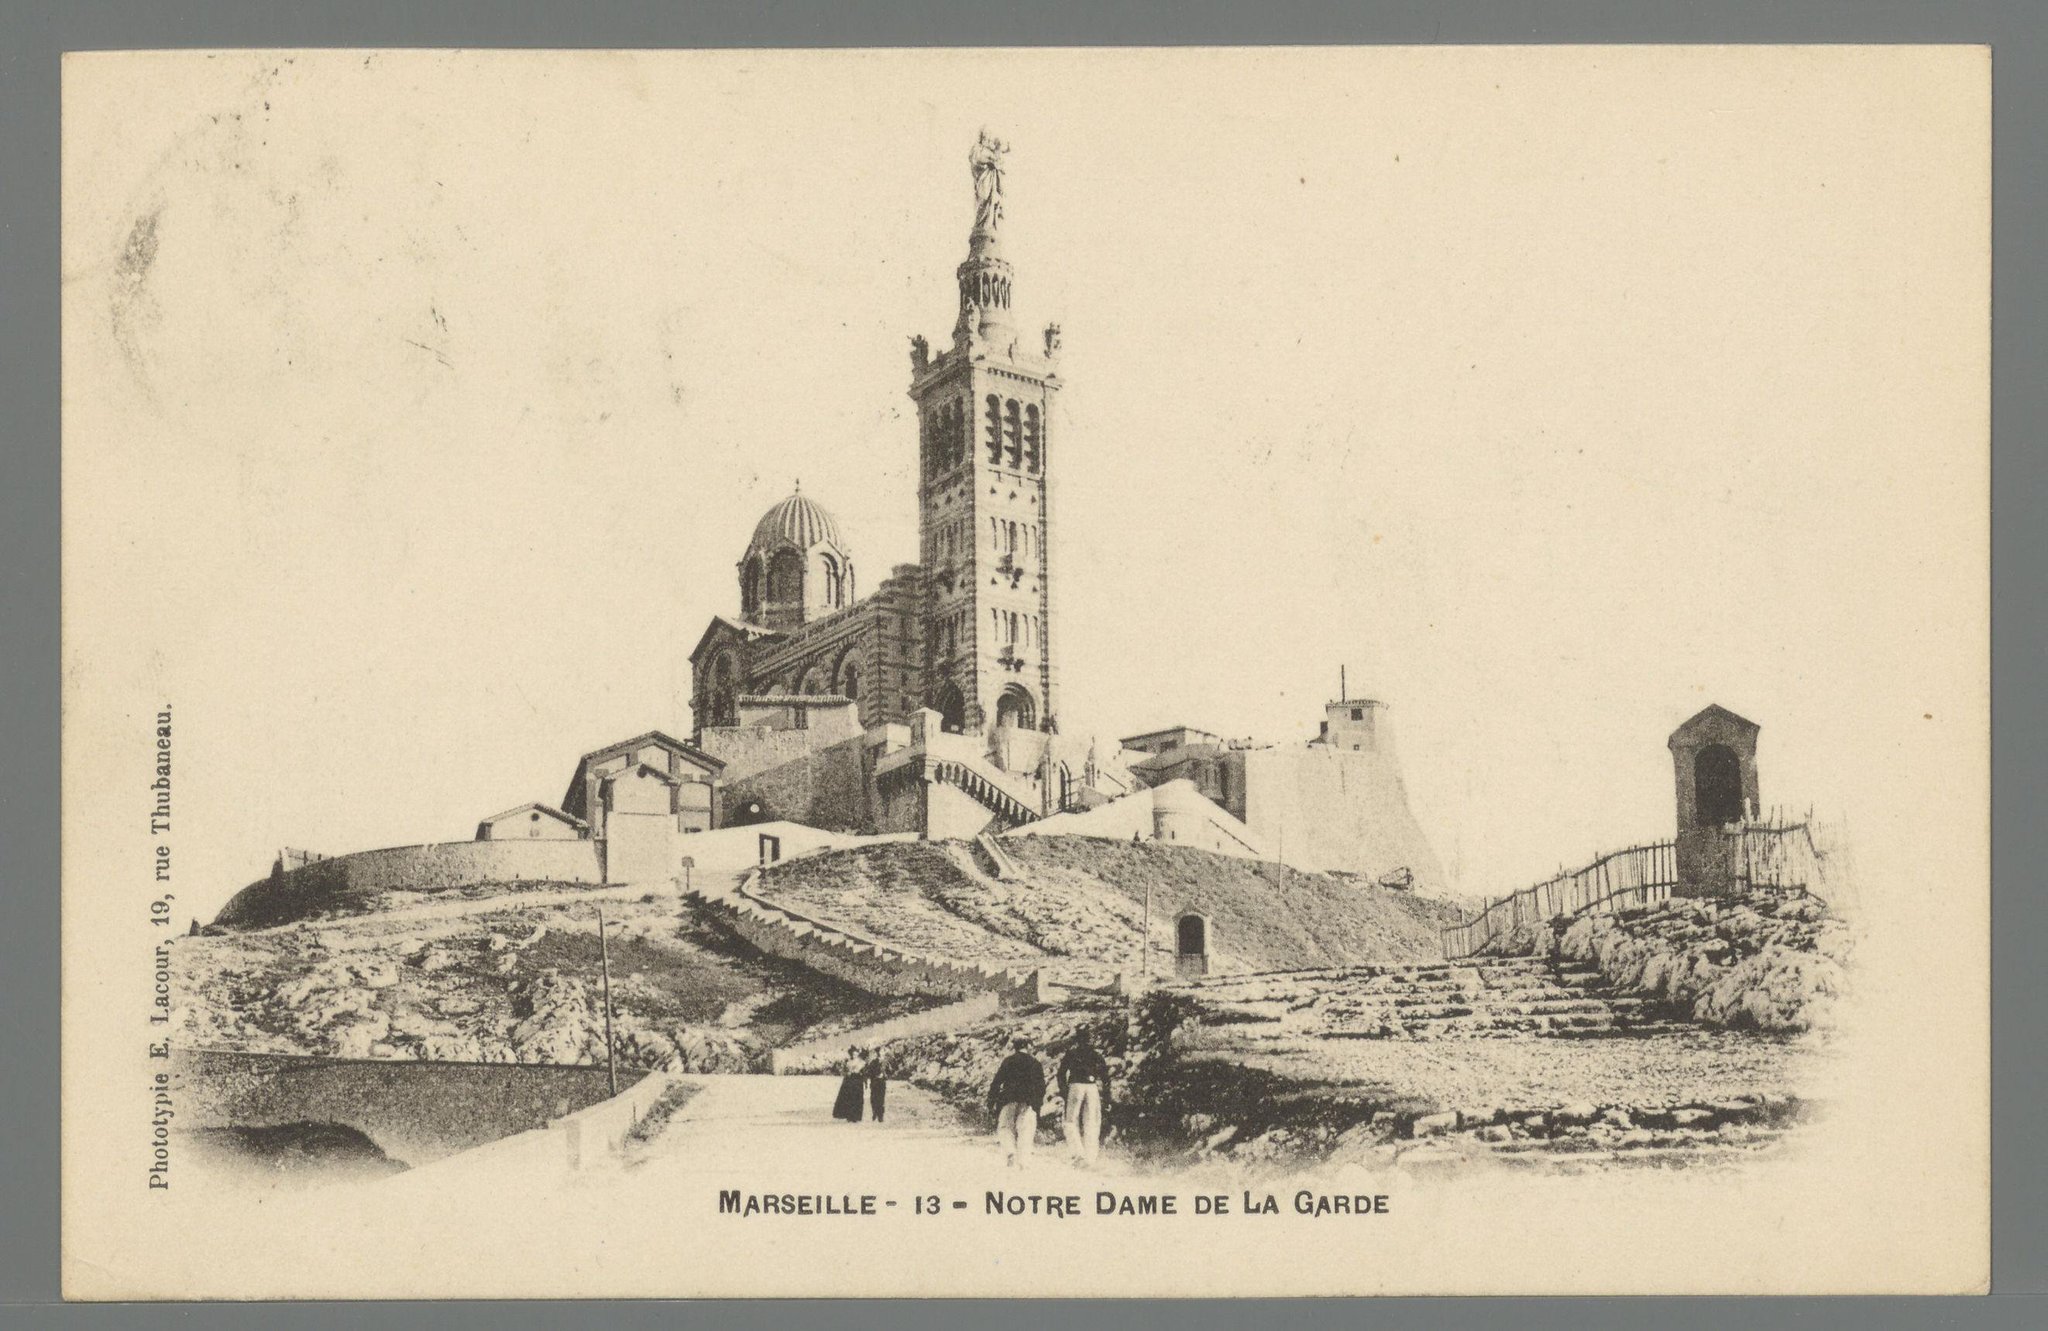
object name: ansichtkaart, prentbriefkaart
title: Marseille (...). Notre Dame de la Garde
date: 1900-1903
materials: cardboard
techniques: photograph, writing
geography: marseille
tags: (high) hill, church (exterior)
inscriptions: postage stamp